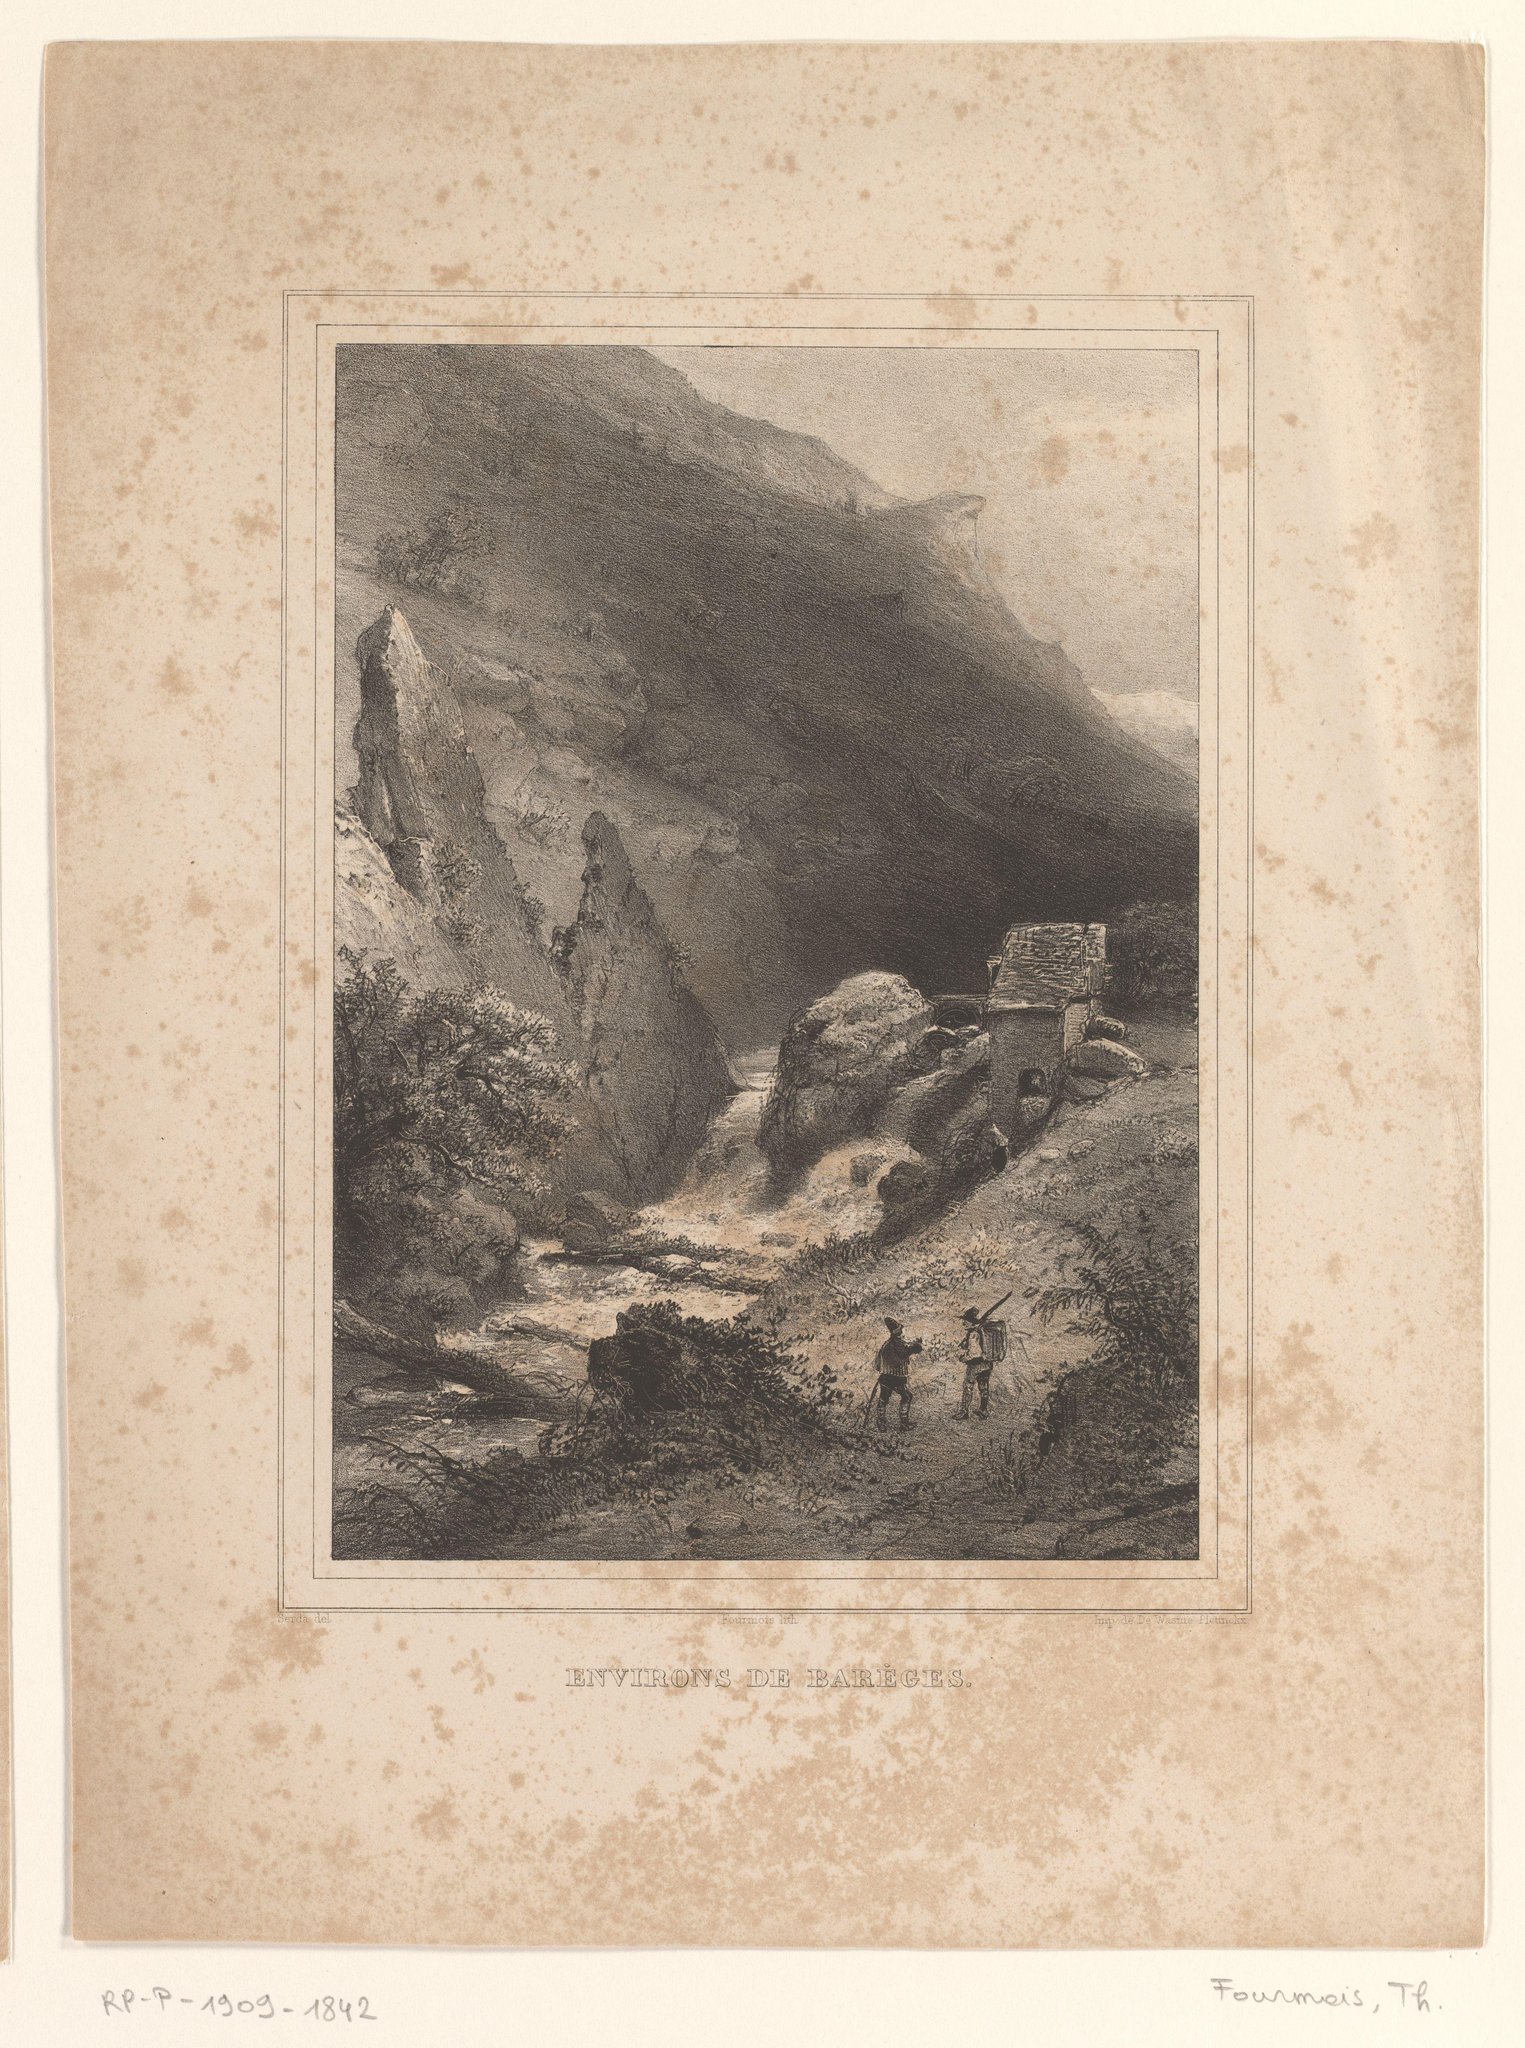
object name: print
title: Environs de Baréges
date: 1835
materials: paper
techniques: lithograph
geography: brussels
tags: waterfall, 'en route', traveller under way, mountains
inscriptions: collector's mark: Lugt 2228